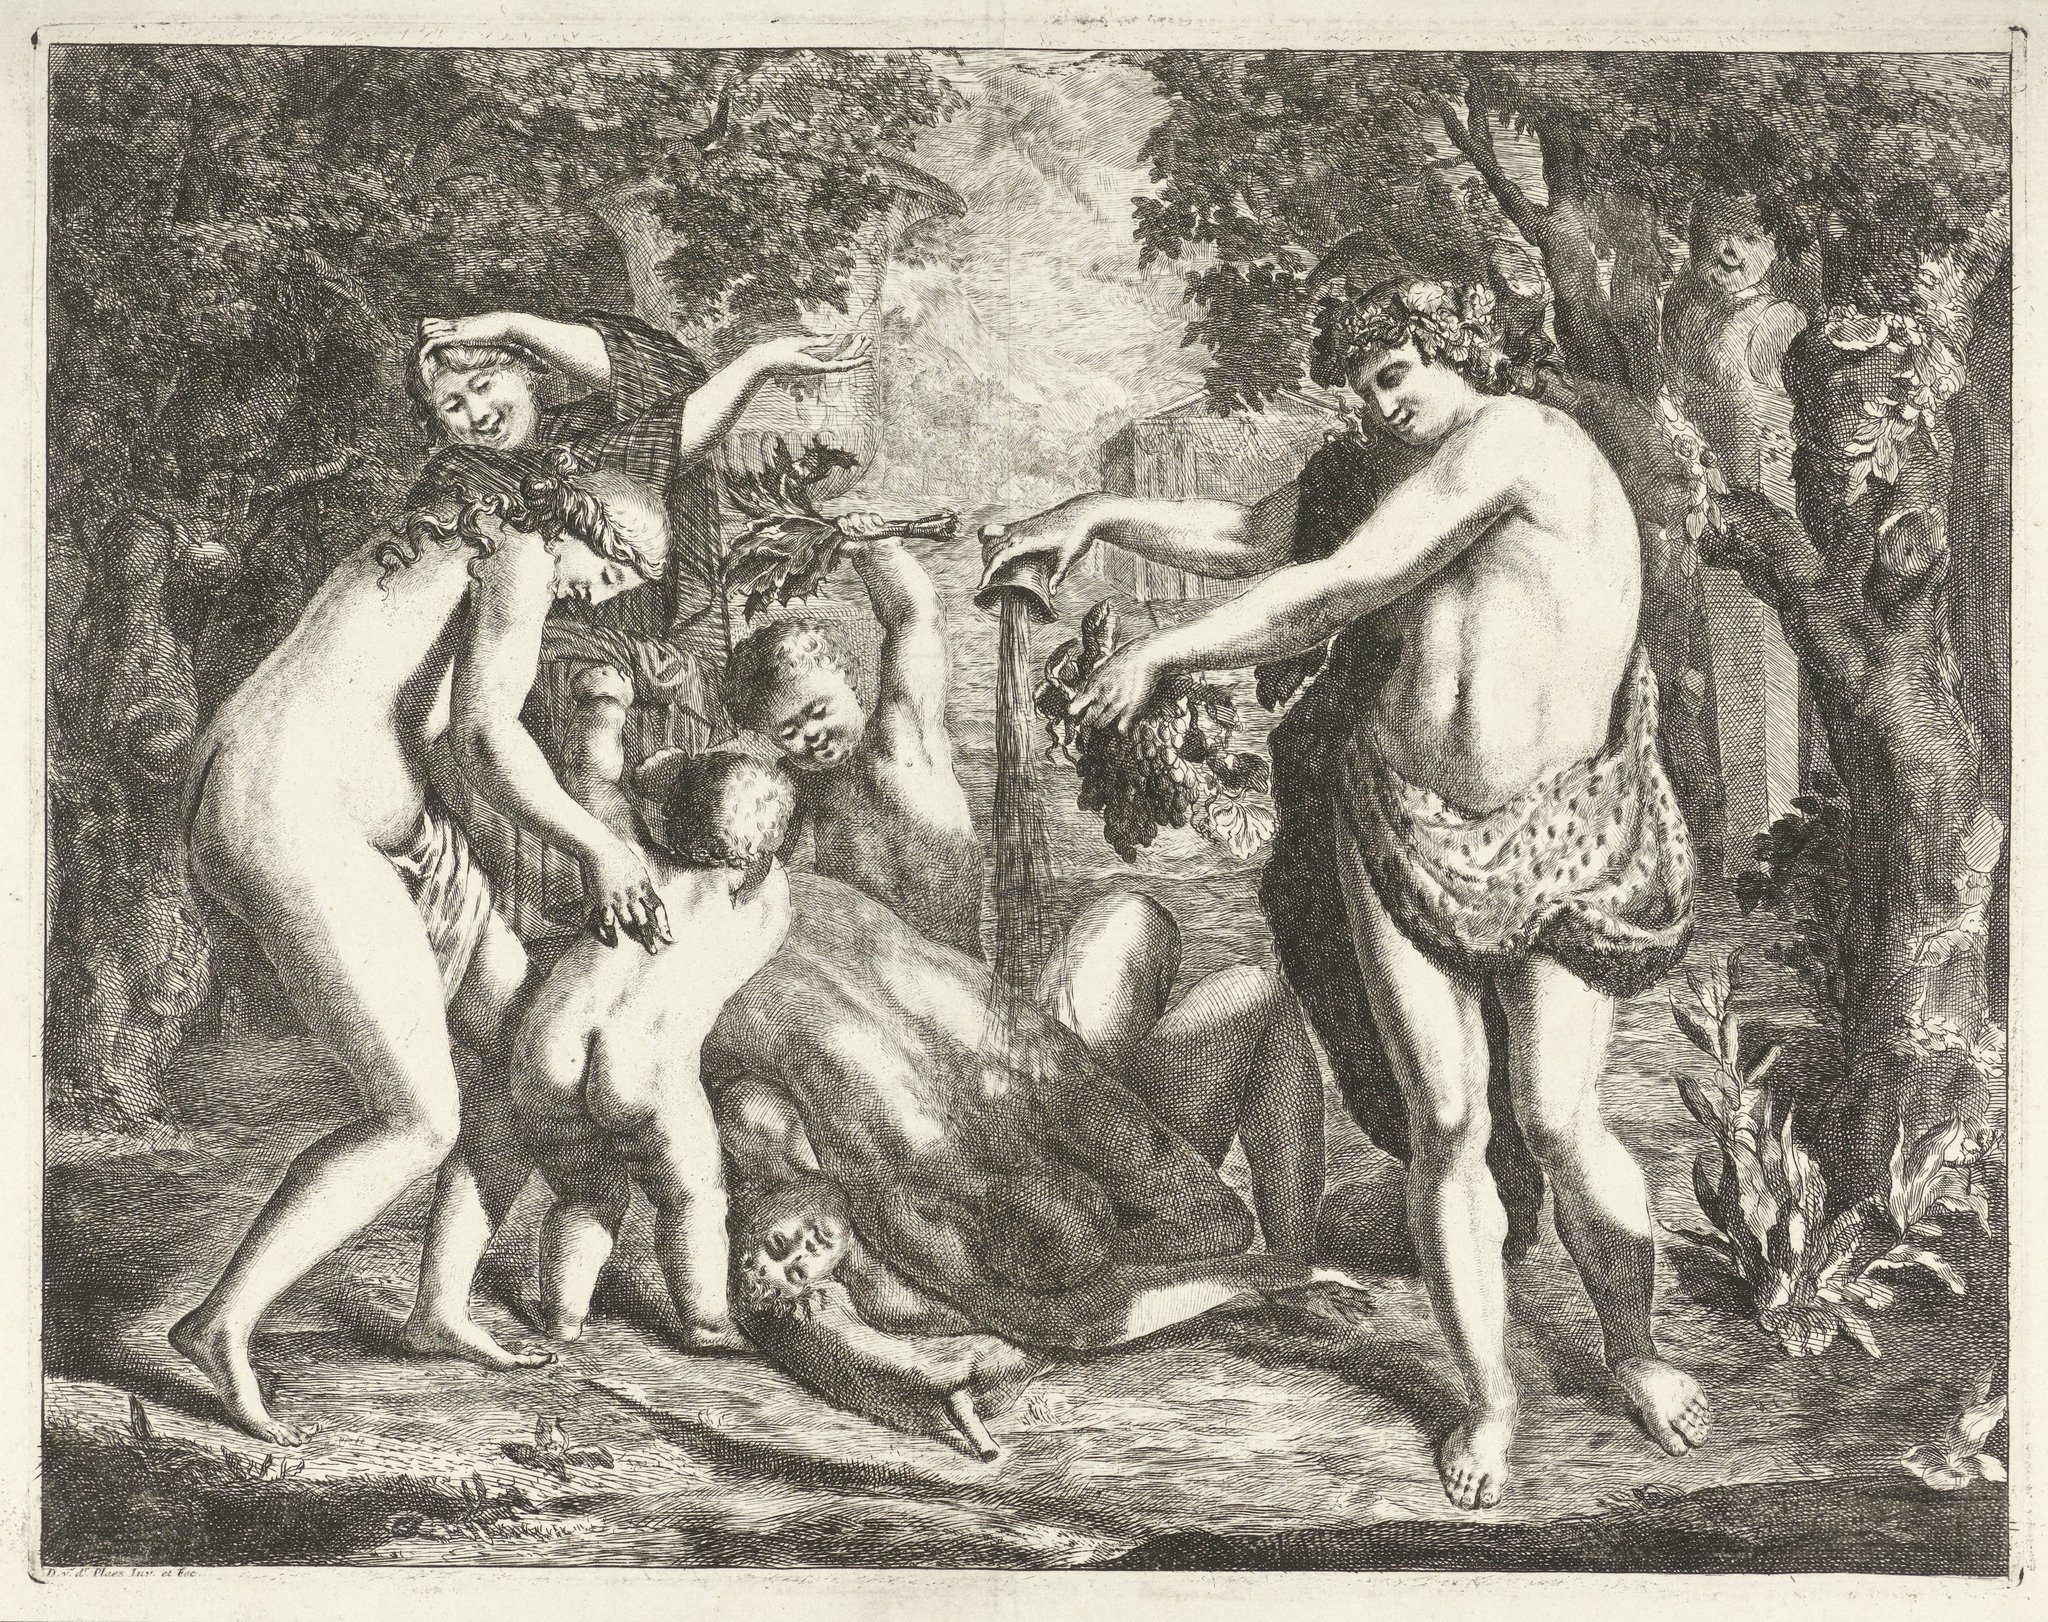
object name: print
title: Landschap met bacchanaal, met Bacchus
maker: david van der plas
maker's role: draughtsman, painter, print maker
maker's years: 1647-1704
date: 1667-1704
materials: paper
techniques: engraving, etching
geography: amsterdam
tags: bacchanal: bacchus with his wine-flushed train (thiasos)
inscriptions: collector's mark: Lugt 2228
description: Landschap met een bacchanaal. Op de voorgrond Bacchus die zijn beker wijn leeg giet boven twee bacchanten die op de grond liggen. Meanaden en putti kijken toe en lachen.